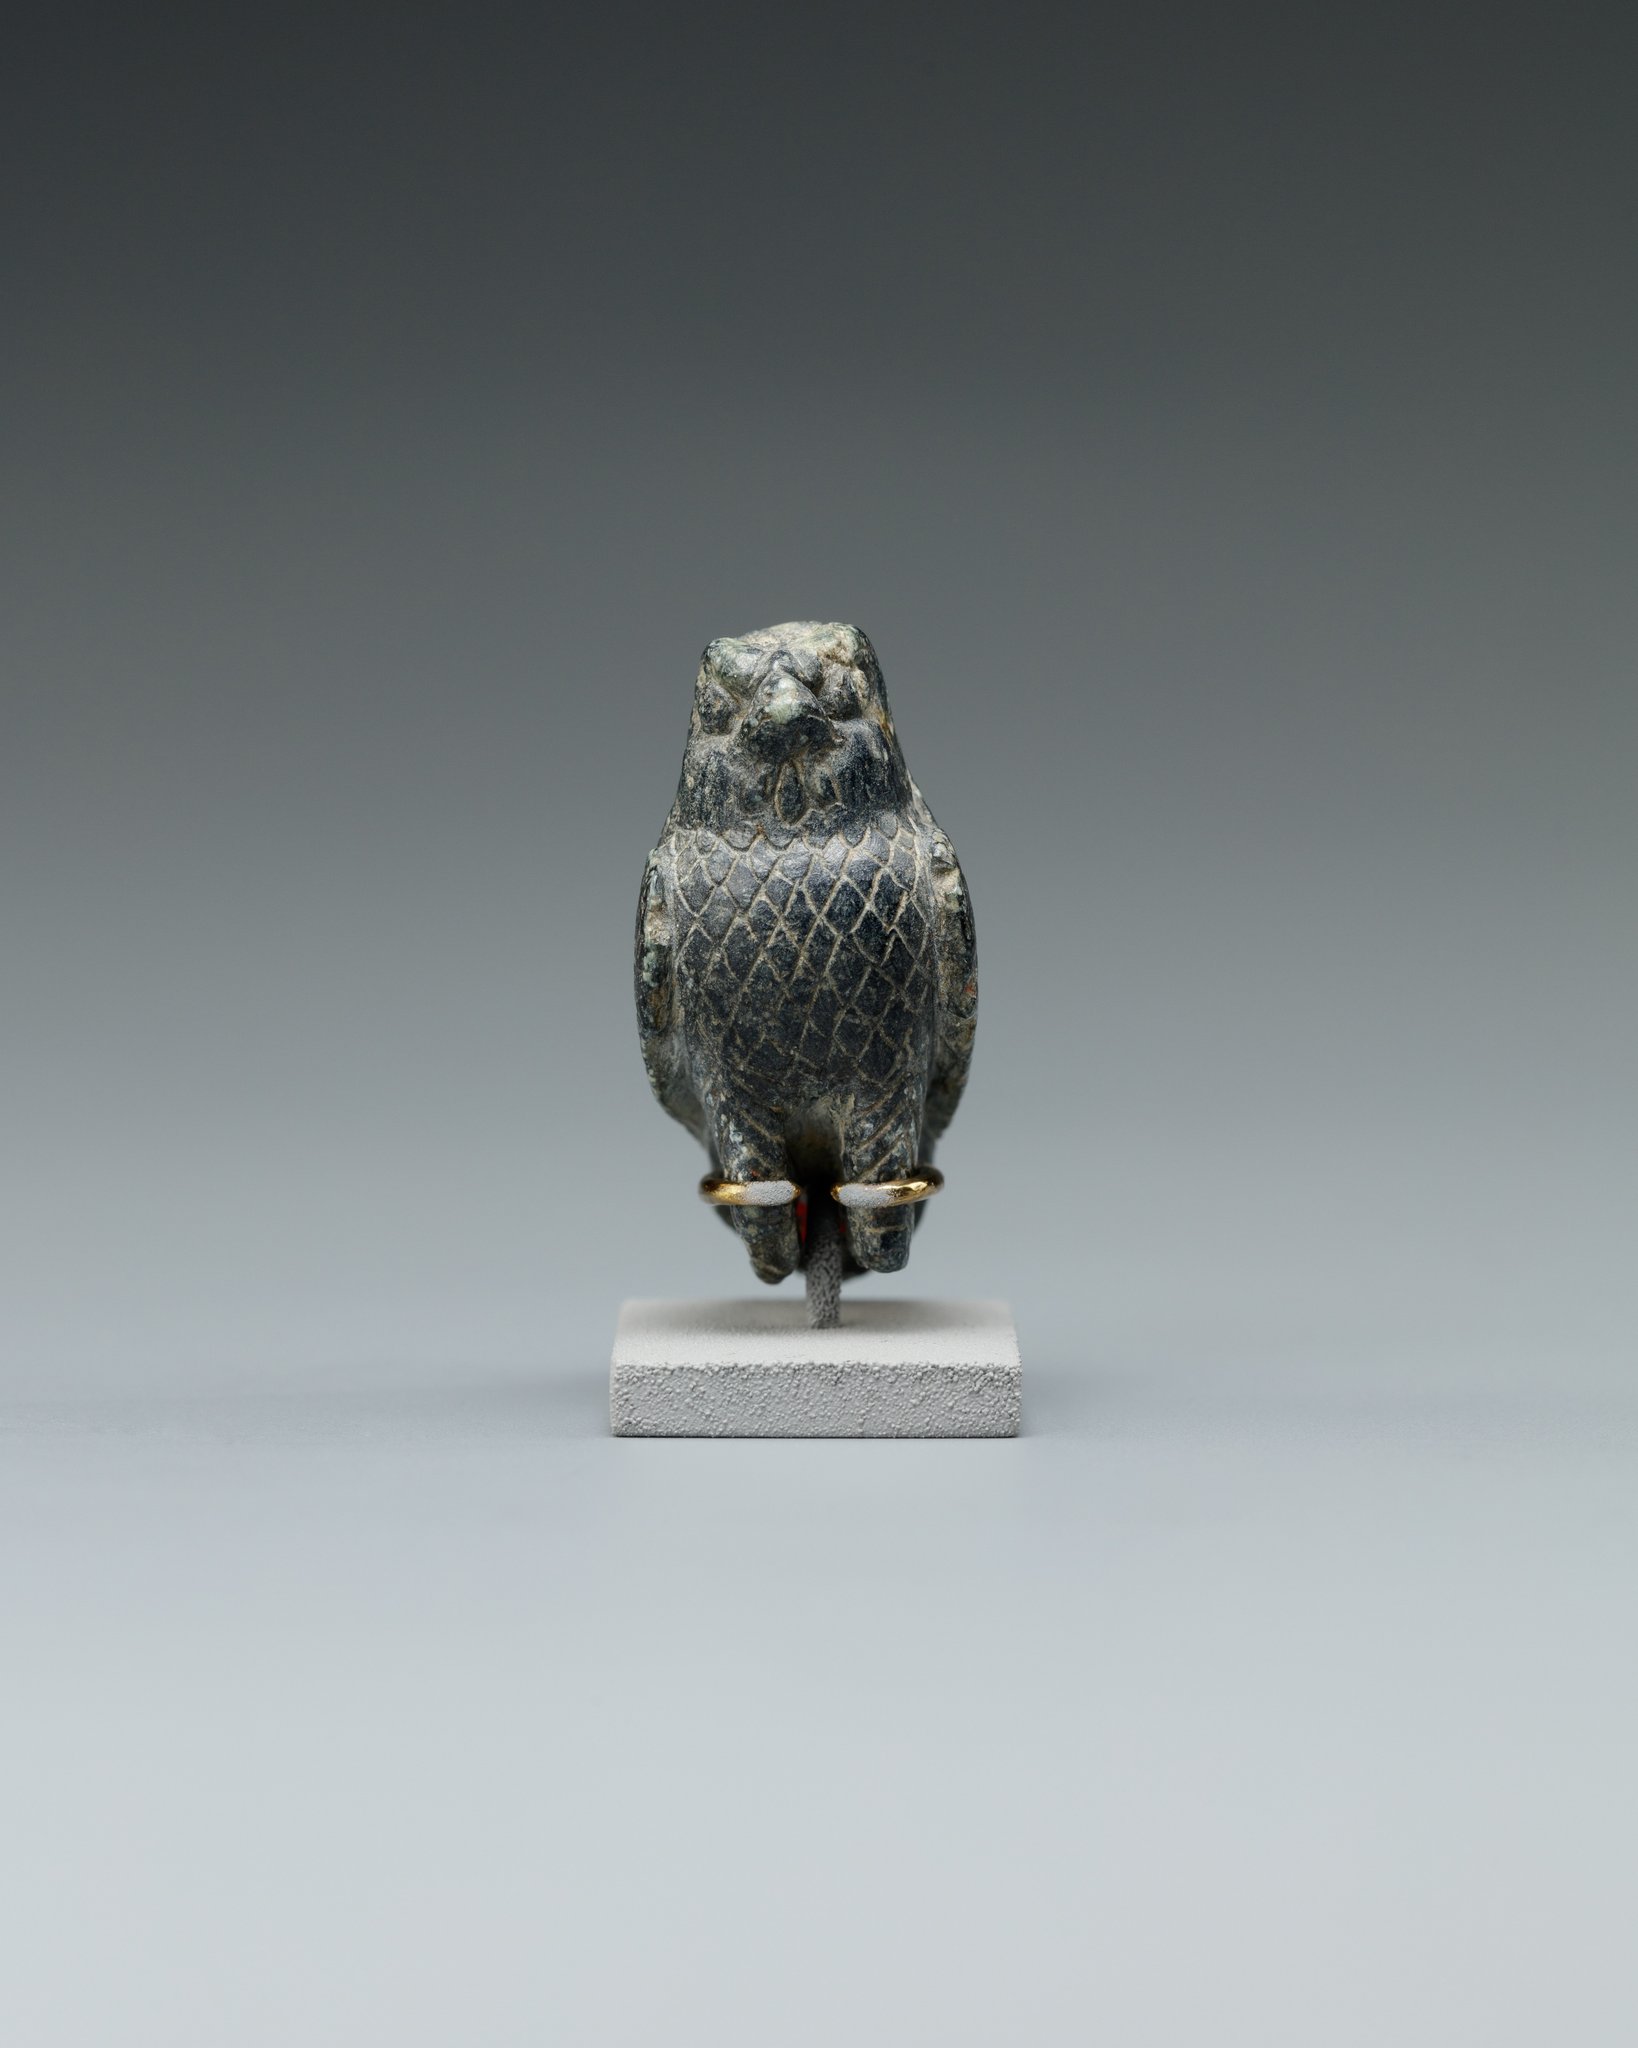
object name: amulet, horus falcon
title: Horus Falcon Amulet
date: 664-332 BCE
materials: stone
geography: egypt